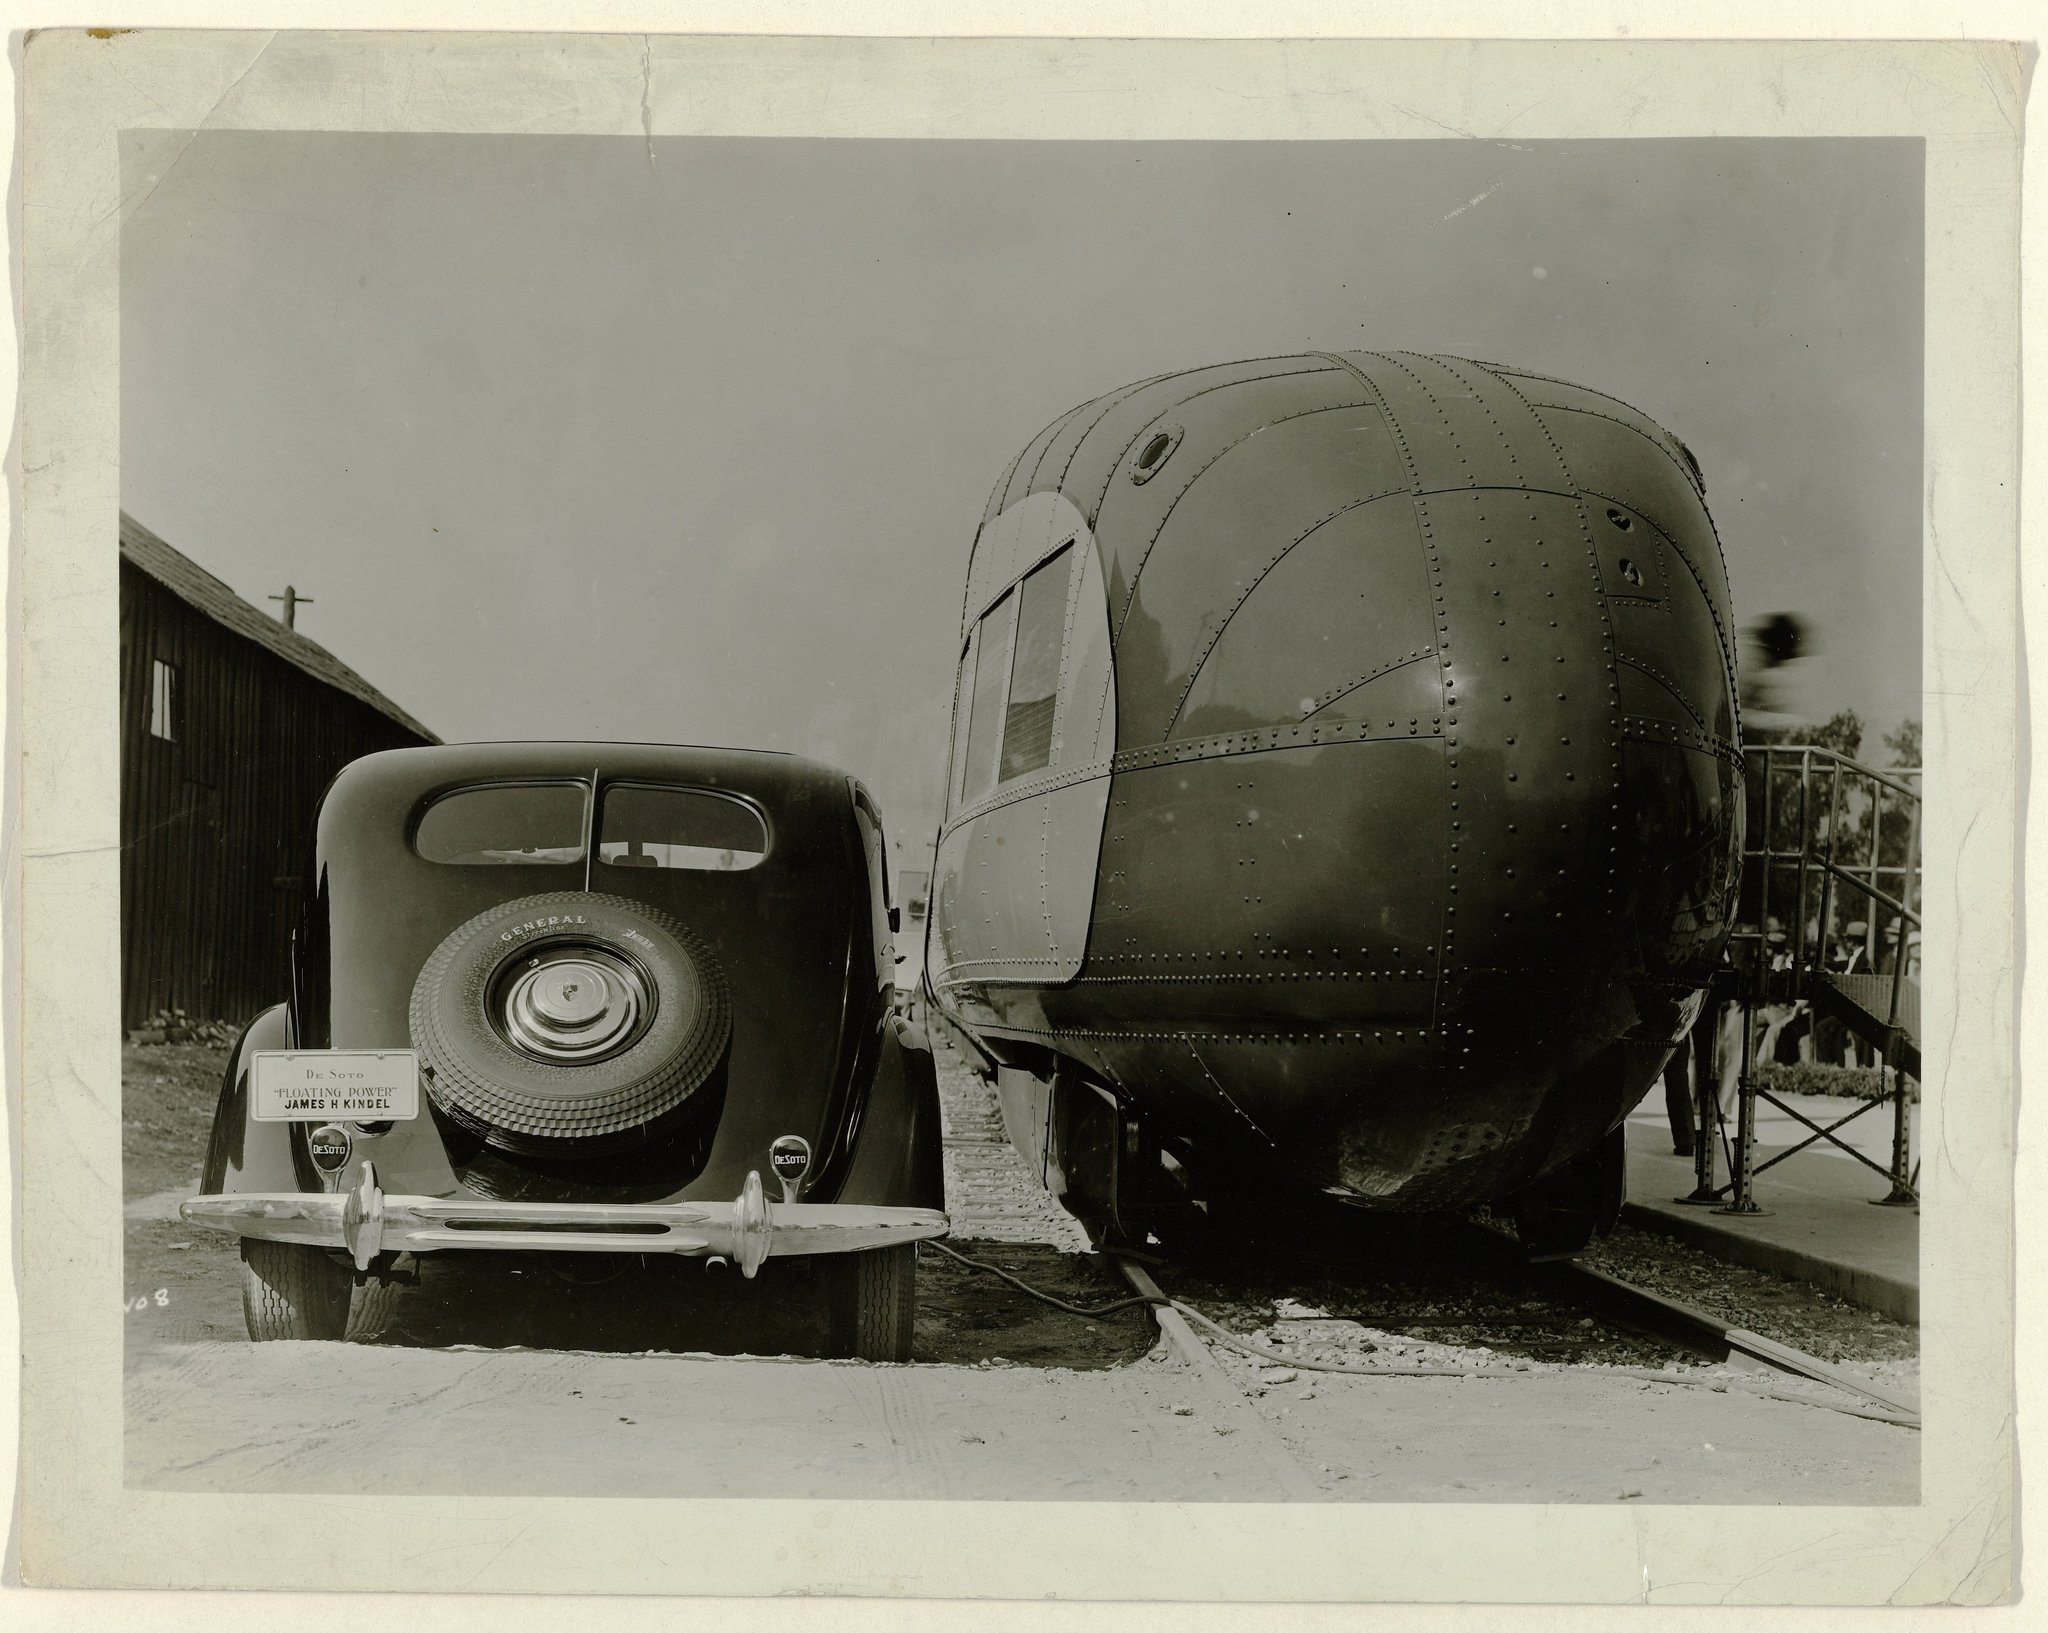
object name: photograph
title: Reclame voor De Soto Floating Power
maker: Anonymous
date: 1929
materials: paper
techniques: gelatin silver print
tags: automobile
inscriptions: inscription: ‘De Soto 1929/ TER INDICATIE VAN DE TOEN BEGONNEN STROOMLIJNING GEPLAATST NAAST TREIN’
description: Gestroomlijnde auto van het automerk De Soto naast een trein.